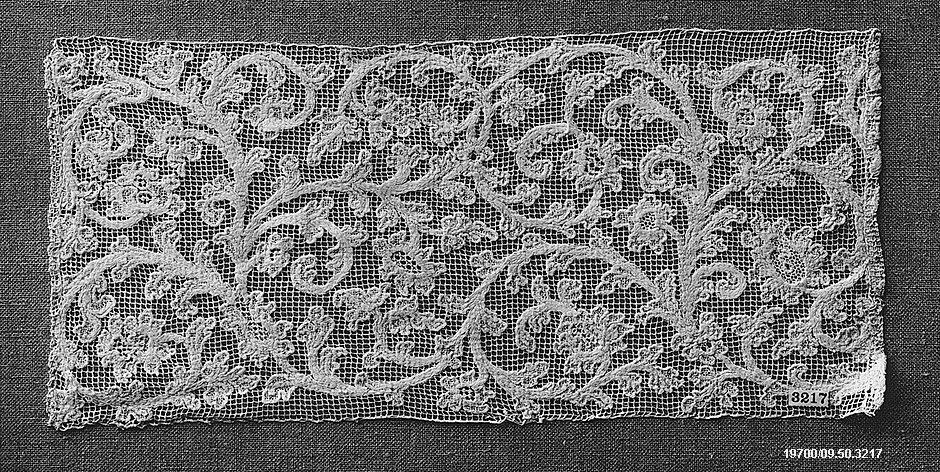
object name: fragment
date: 1701-1800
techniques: embroidery